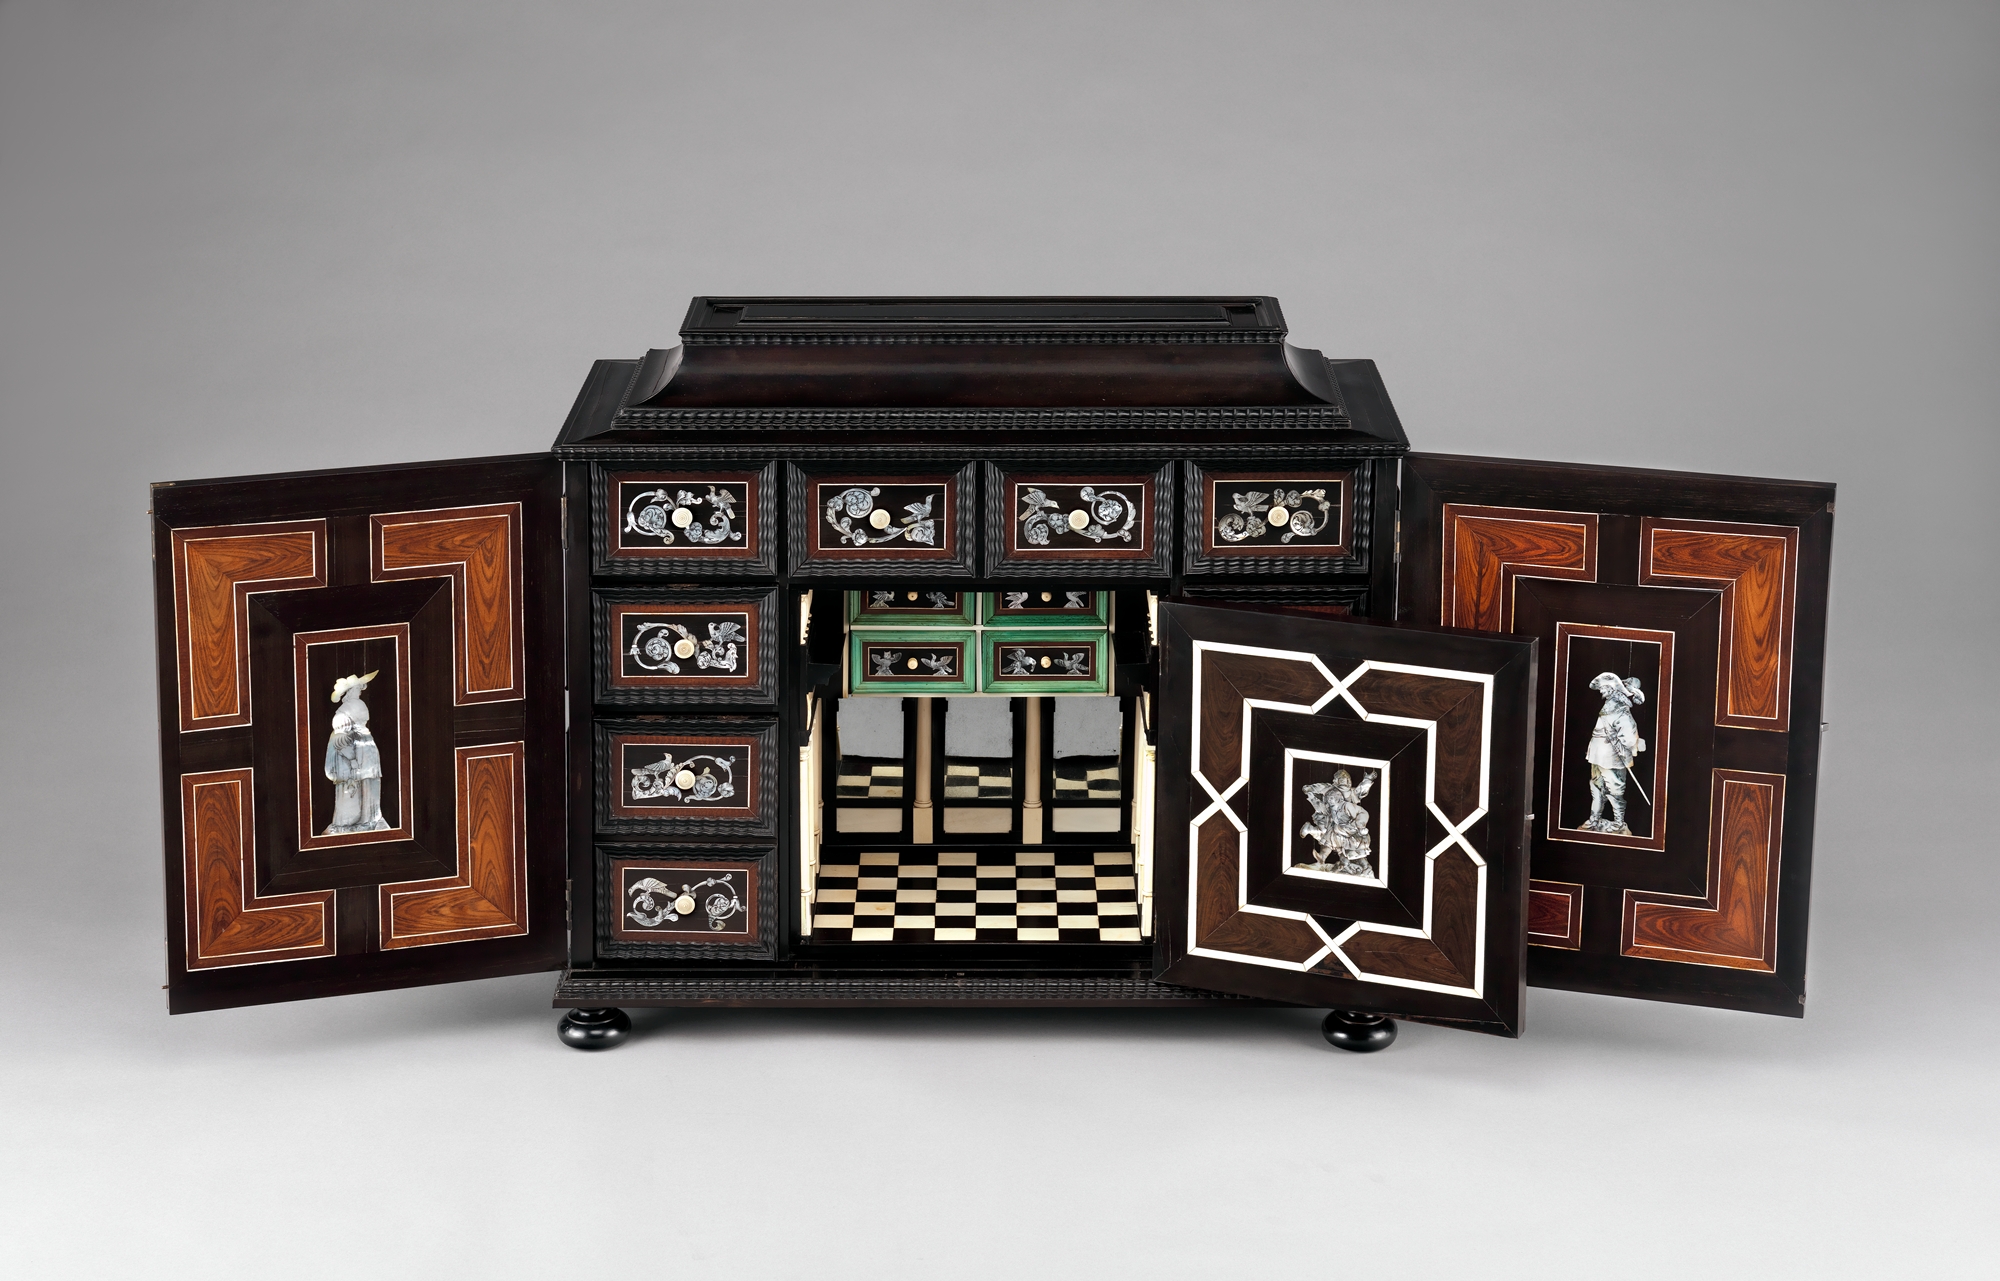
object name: cabinet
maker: herman doomer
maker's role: maker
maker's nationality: dutch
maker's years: 1595-1650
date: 1640-1650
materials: bone, wood, ivory, mother of pearl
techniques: stain, veneering